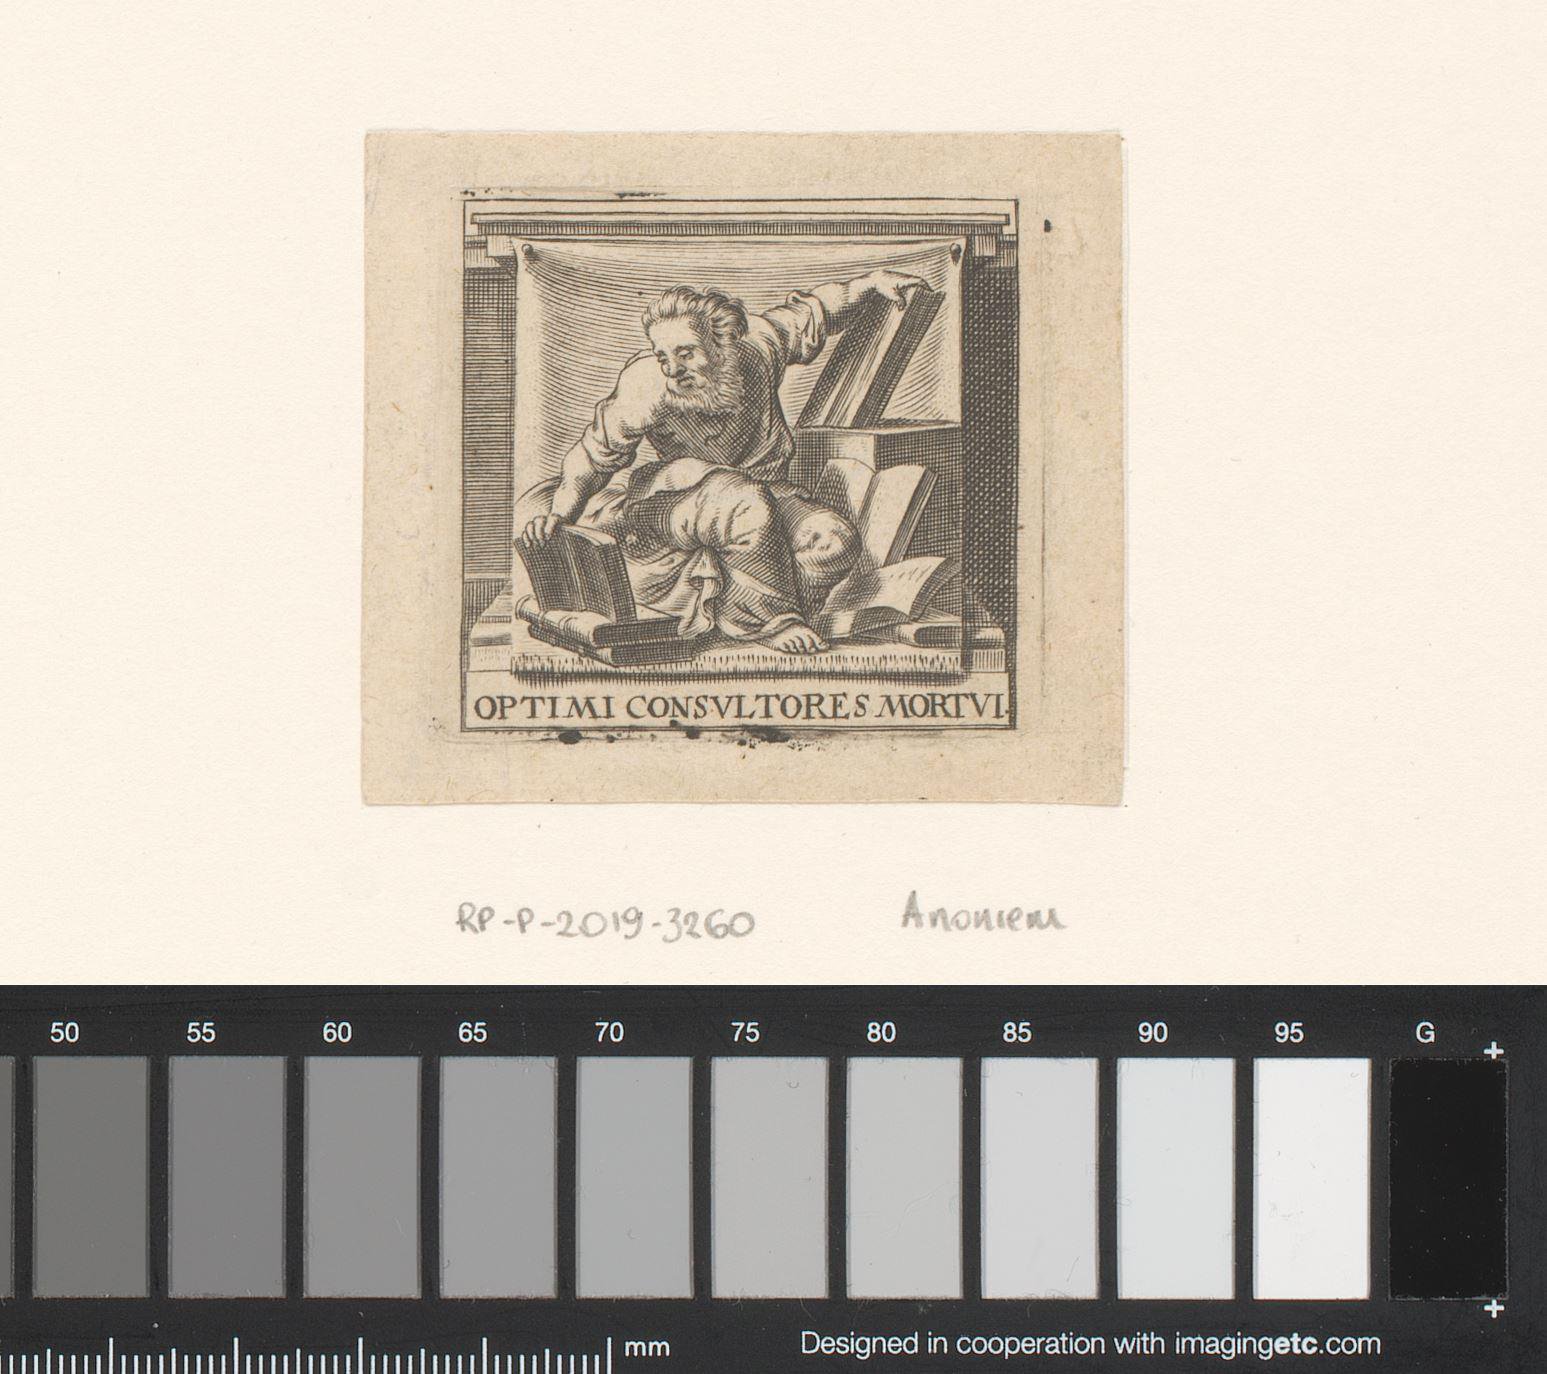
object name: print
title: Optimi Consultores Mortui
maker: Anonymous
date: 1600-1699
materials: paper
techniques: engraving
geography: france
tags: reading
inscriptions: number: ‘261’, number: ‘136’, collector's mark: Lugt 2228